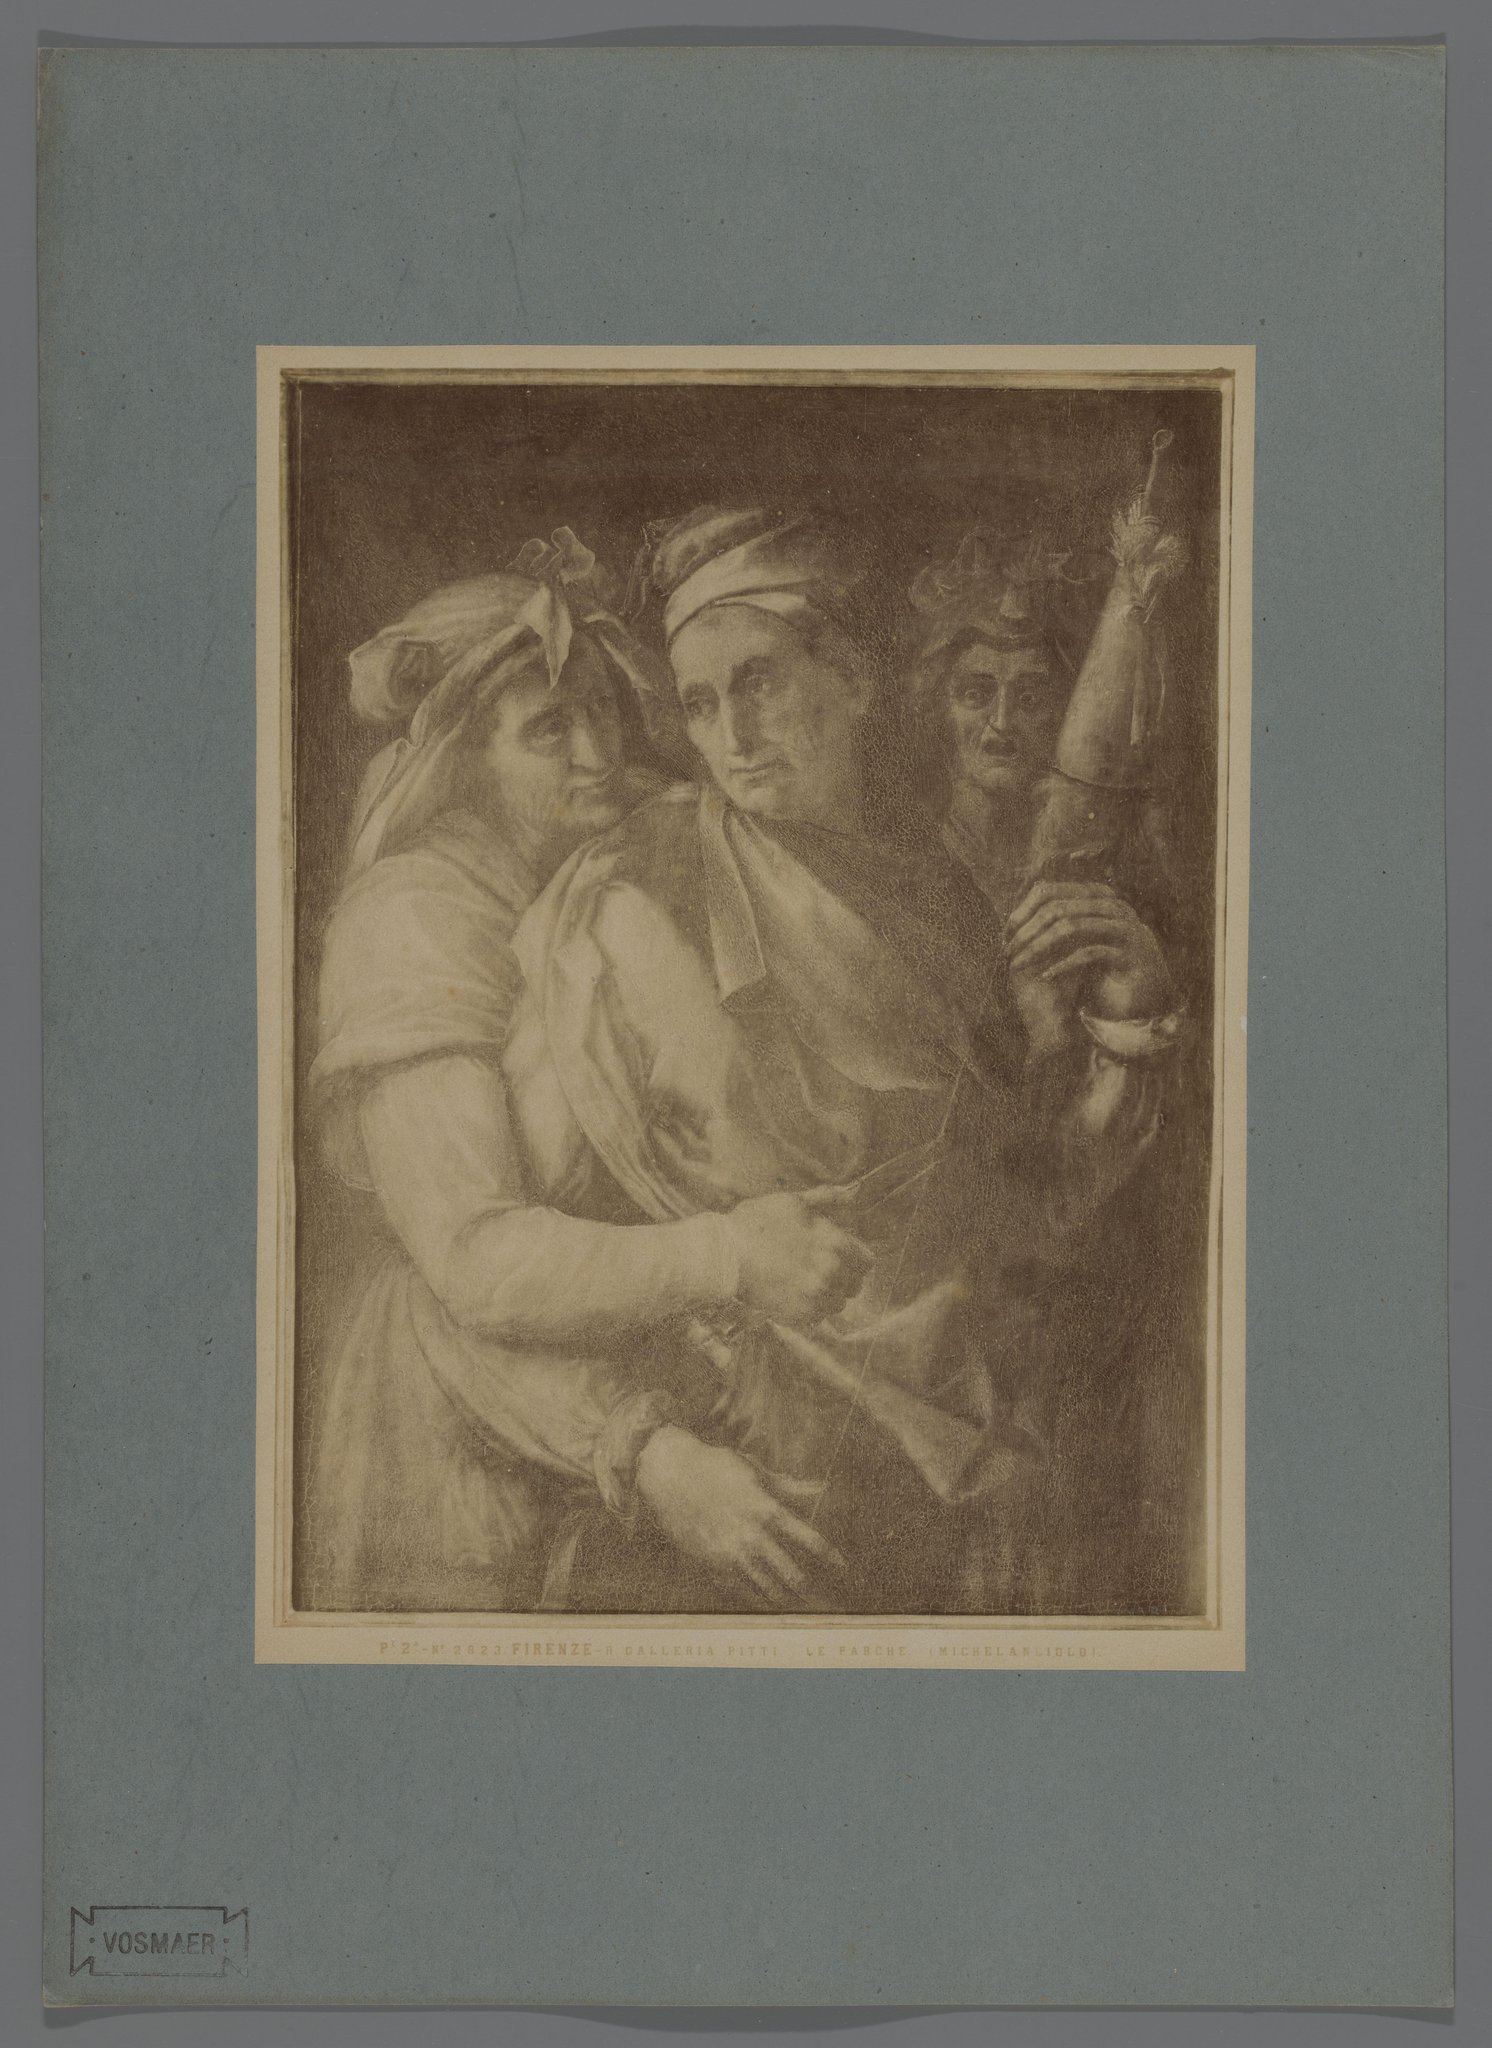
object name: reproduction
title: Florence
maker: rosso fiorentino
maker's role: draughtsman, painter, print maker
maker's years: 1494-1541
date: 1857-1900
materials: cardboard, paper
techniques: albumen print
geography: florence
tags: picture, painting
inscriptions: number: ‘Pt. 2A-No. 2823.’, collector's mark: ‘VOSMAER’